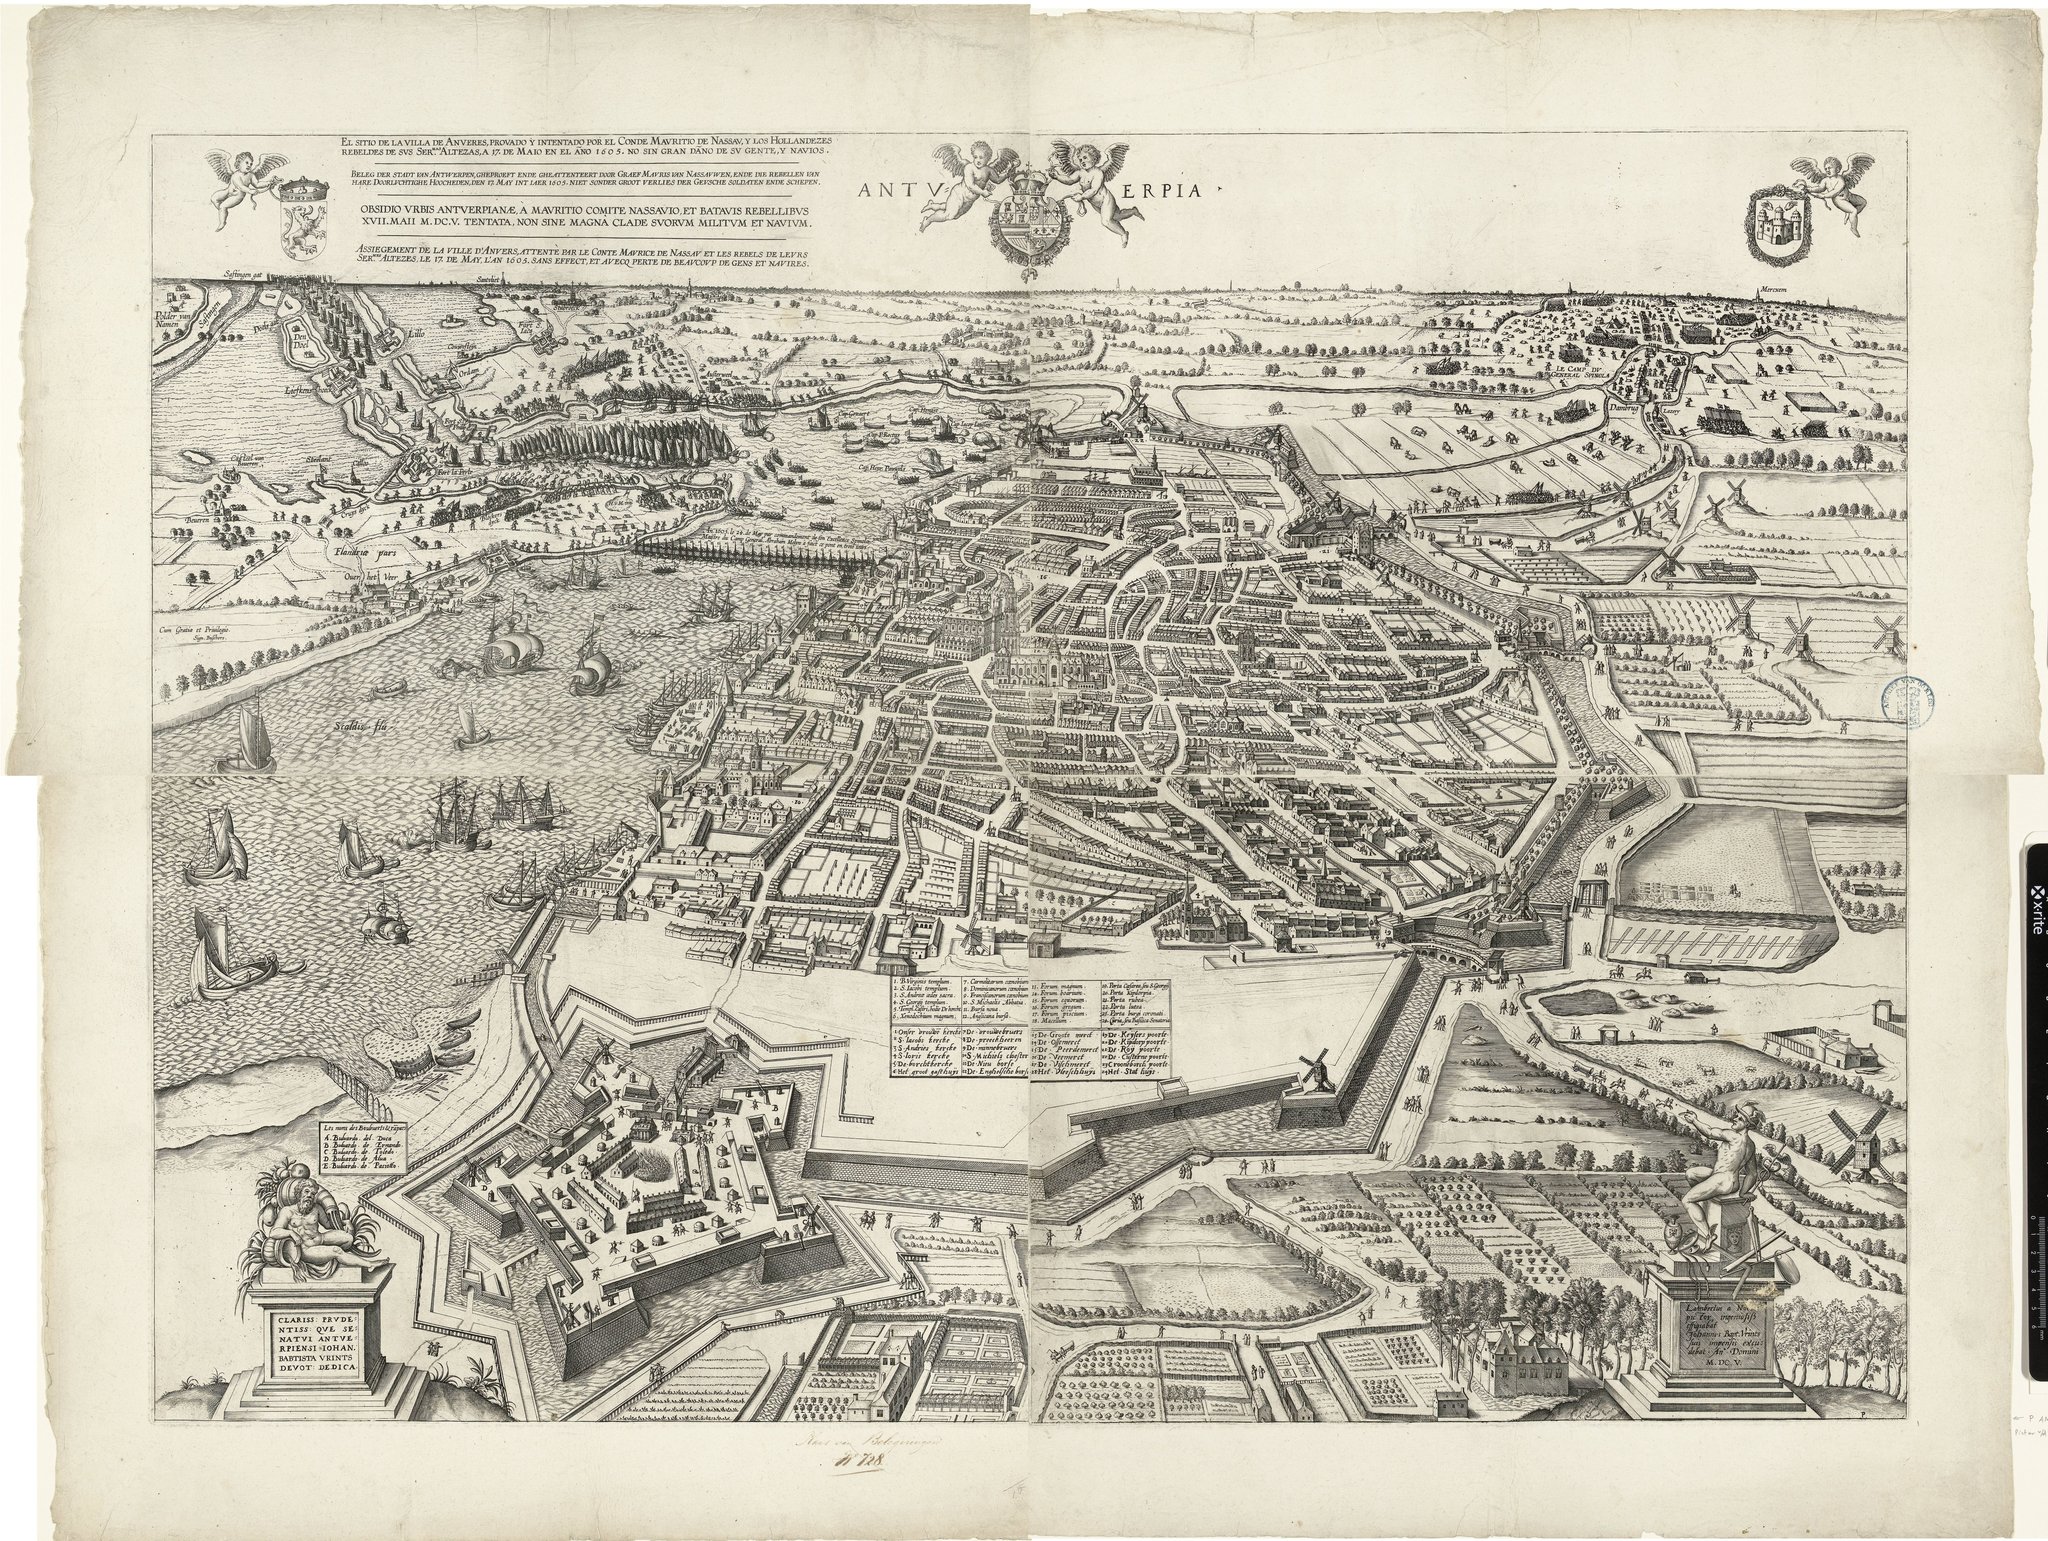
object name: print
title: Obsidio urbis Antverpianae, a Mauritio comite Nassauio, et Batavis rebellibus XVII. maii M.DC.V. tentata, non sine magna clade suorum militum et navium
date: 1569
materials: paper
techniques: engraving, etching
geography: antwerp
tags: ernst casimir graaf van nassau-dietz, maps of cities, battle (+ land forces), antwerp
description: Latere staat van de kaart gegraveerd door Pieter van der Heyden naar ontwerp van Lambert van Noort, oorspronkelijk in 1569 uitgegeven door Hans Liefrinck. In ets zijn toegevoegd aan de twee bovenplaten de gevechten rond de mislukte aanslag van 1605. Dit object is omwille van een betere presentatie virtueel samengevoegd maar bestaat fysiek uit losse onderdelen.